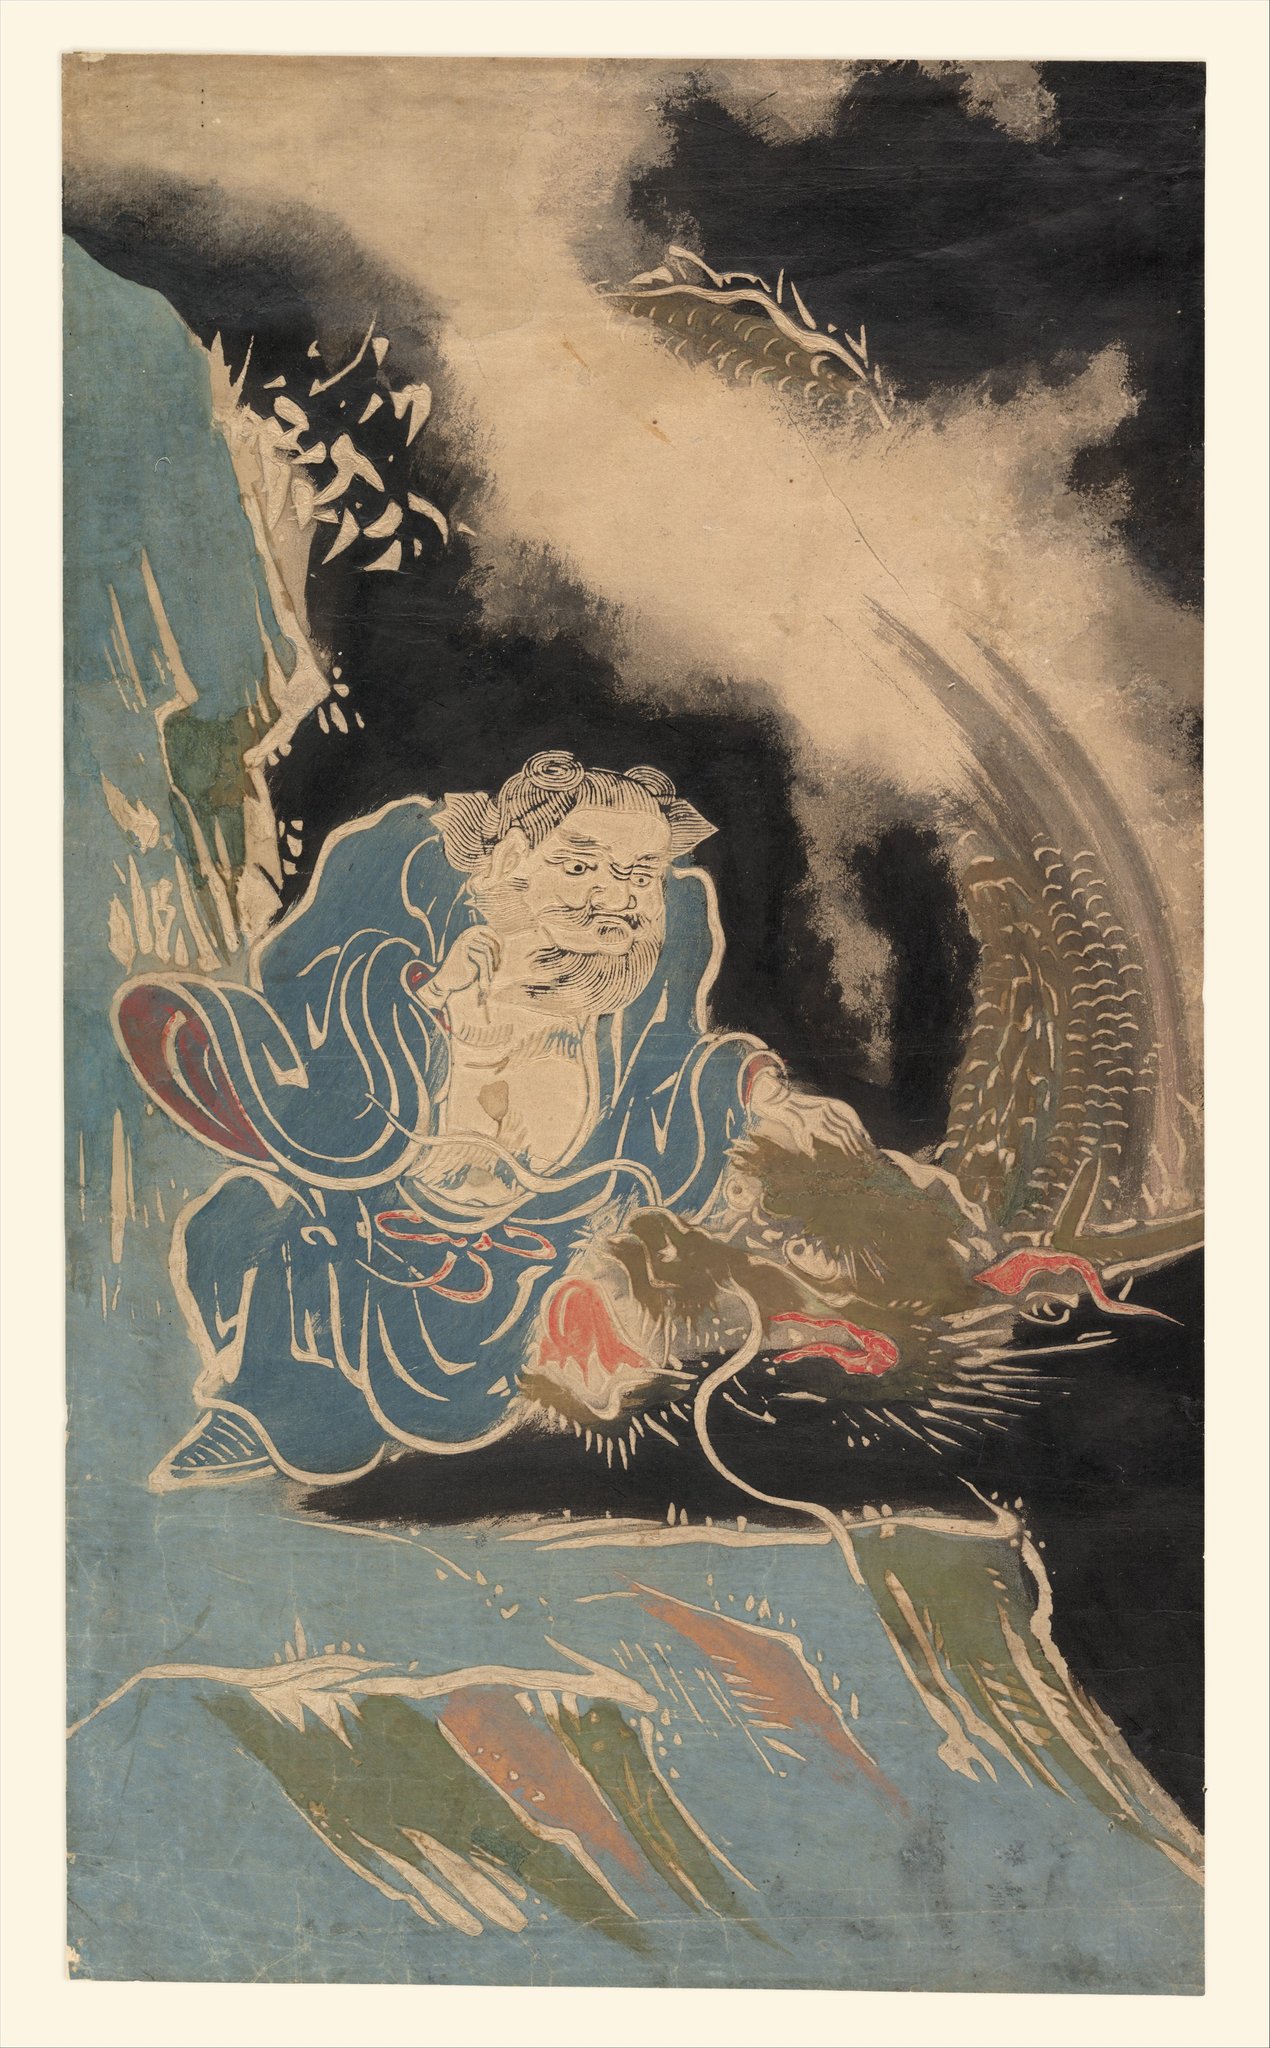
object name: print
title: Daoist Immortal with Dragon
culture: japanese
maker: unidentified artist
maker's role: artist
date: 1801-1900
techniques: incising, pressed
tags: men,dragons,daoism